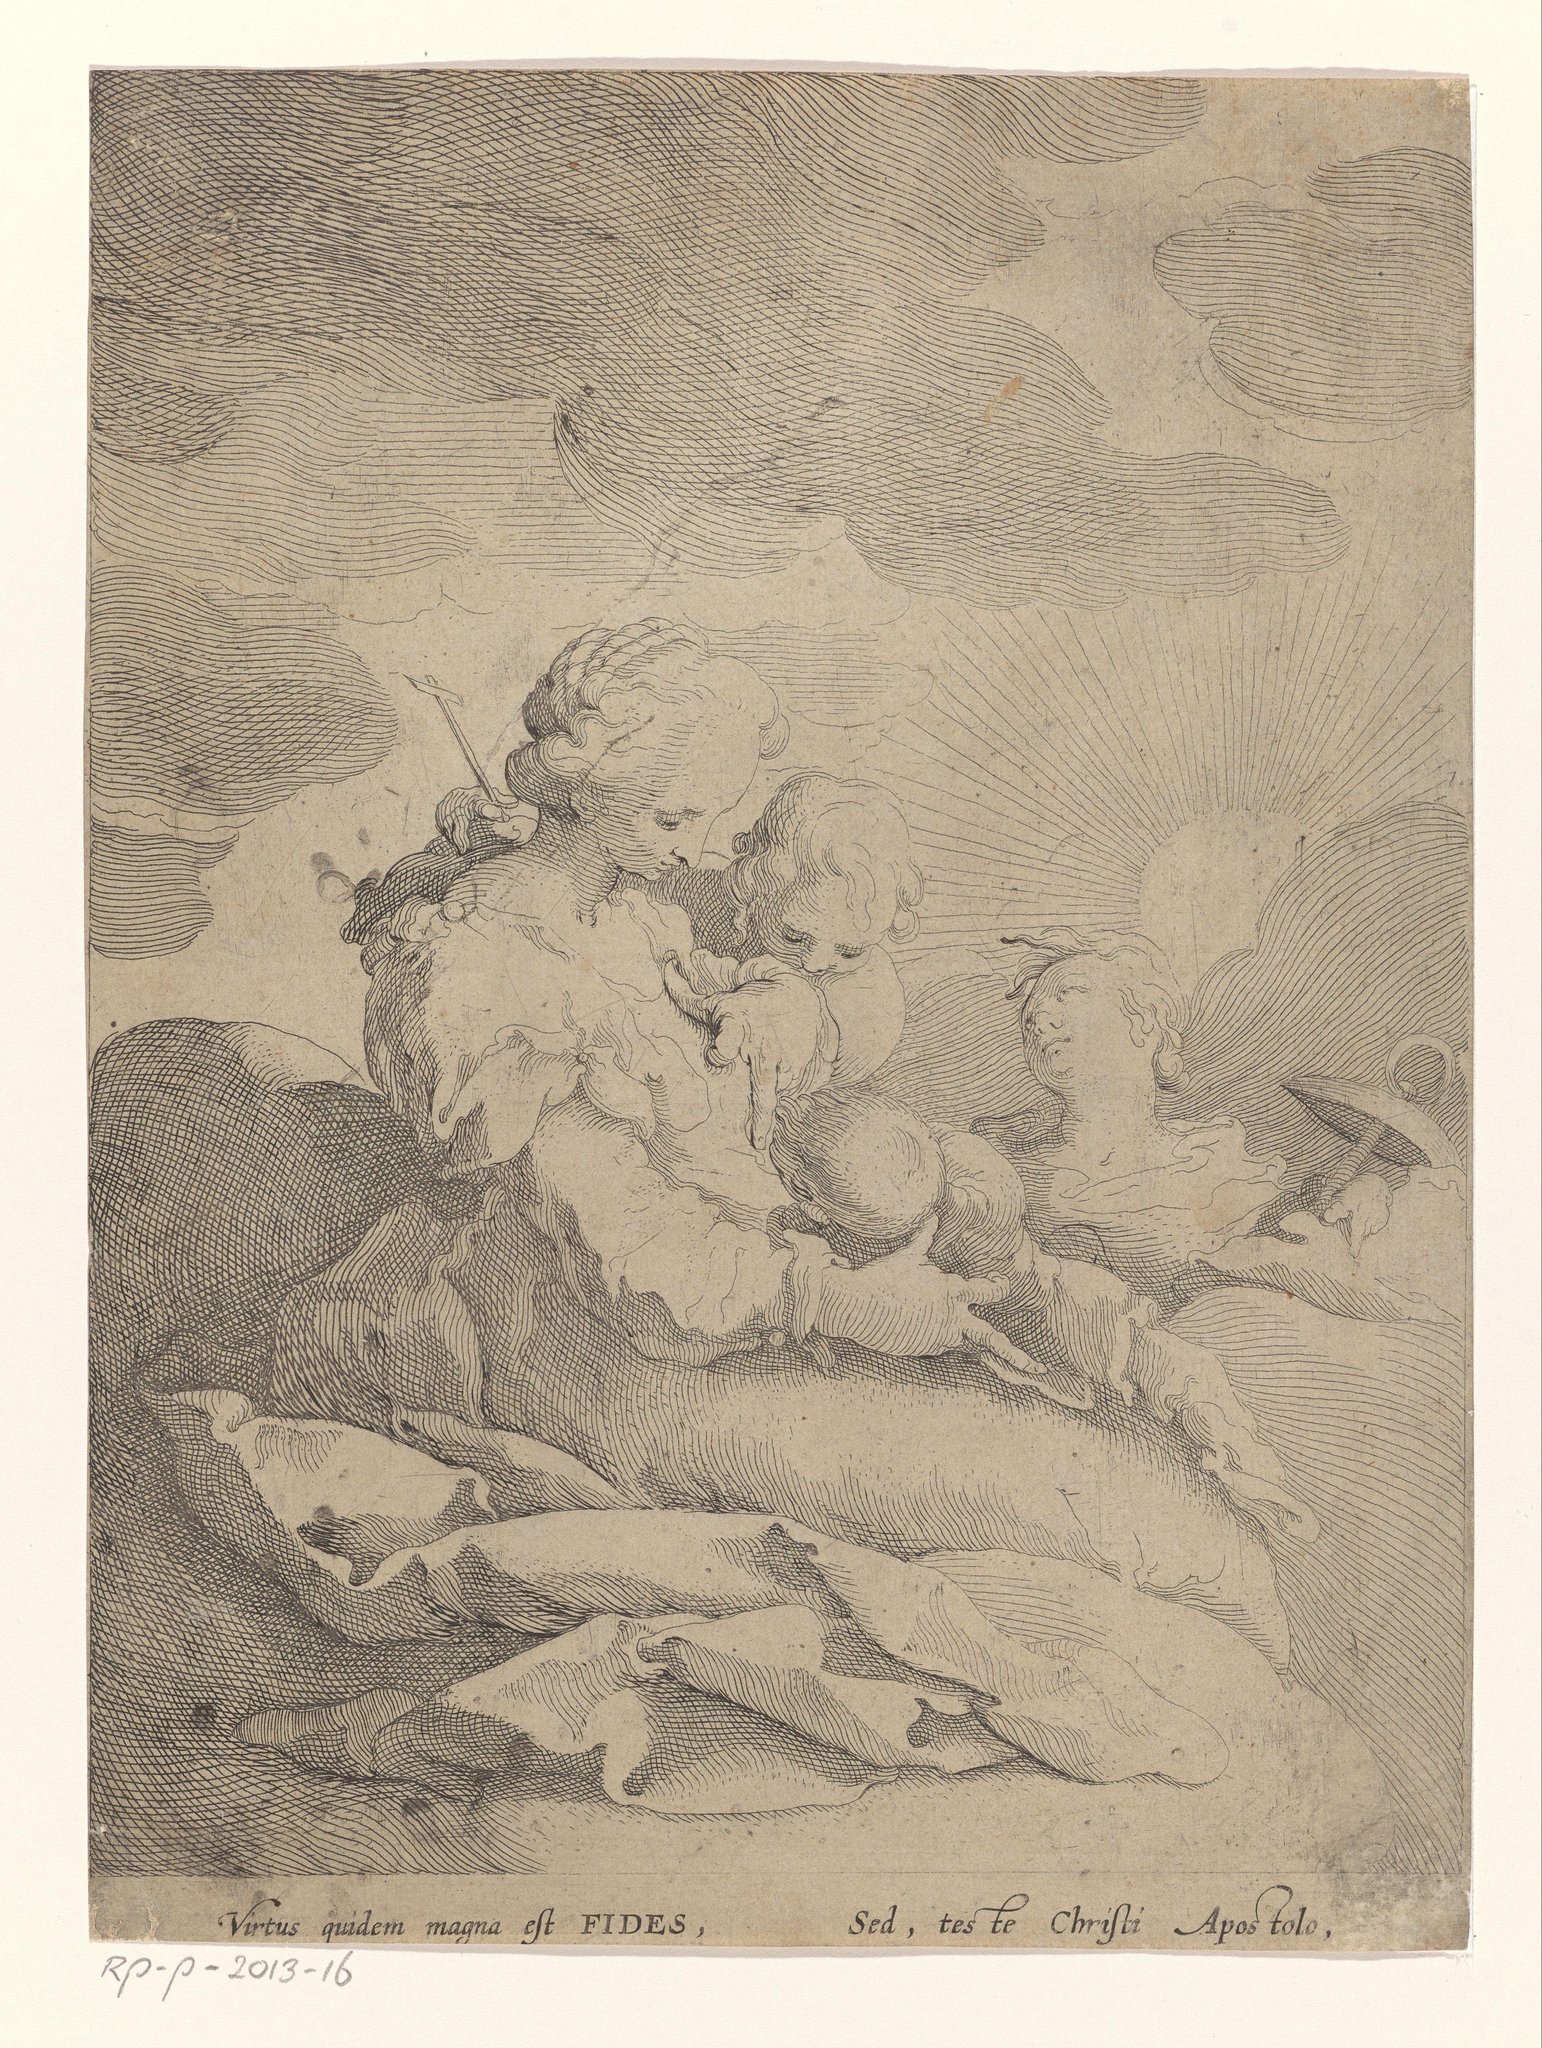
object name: print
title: Caritas met Fides en Spes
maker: gerrit pietersz. sweelink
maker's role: draughtsman, painter, print maker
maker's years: 1566-1612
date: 1593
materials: paper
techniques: etching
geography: amsterdam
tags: the three theological virtues, the seven virtues (symbolized), 'sapientia', mother of the seven virtues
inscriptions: inscription: ‘Virtus magna quidem est FIDES, Sed, teste Christi Apostolo’, watermark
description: Het afsnijden van de onderste regel van het opschrift in de marge is vermoedelijk ingegeven door de inhoud. In het latijnse onderschrift wordt de (Naaste-) Liefde de belangrijkste deugd genoemd en op gezag van de apostel Paulus boven het Geloof gesteld. Het is goed denkbaar dat een bevindelijke bezitter aanstoot nam aan deze laatste regel en deze heeft verwijderd. Afdruk van de eerste staat, vóór de toevoeging van het monogram en het uitgeversadres van Johan Starter.